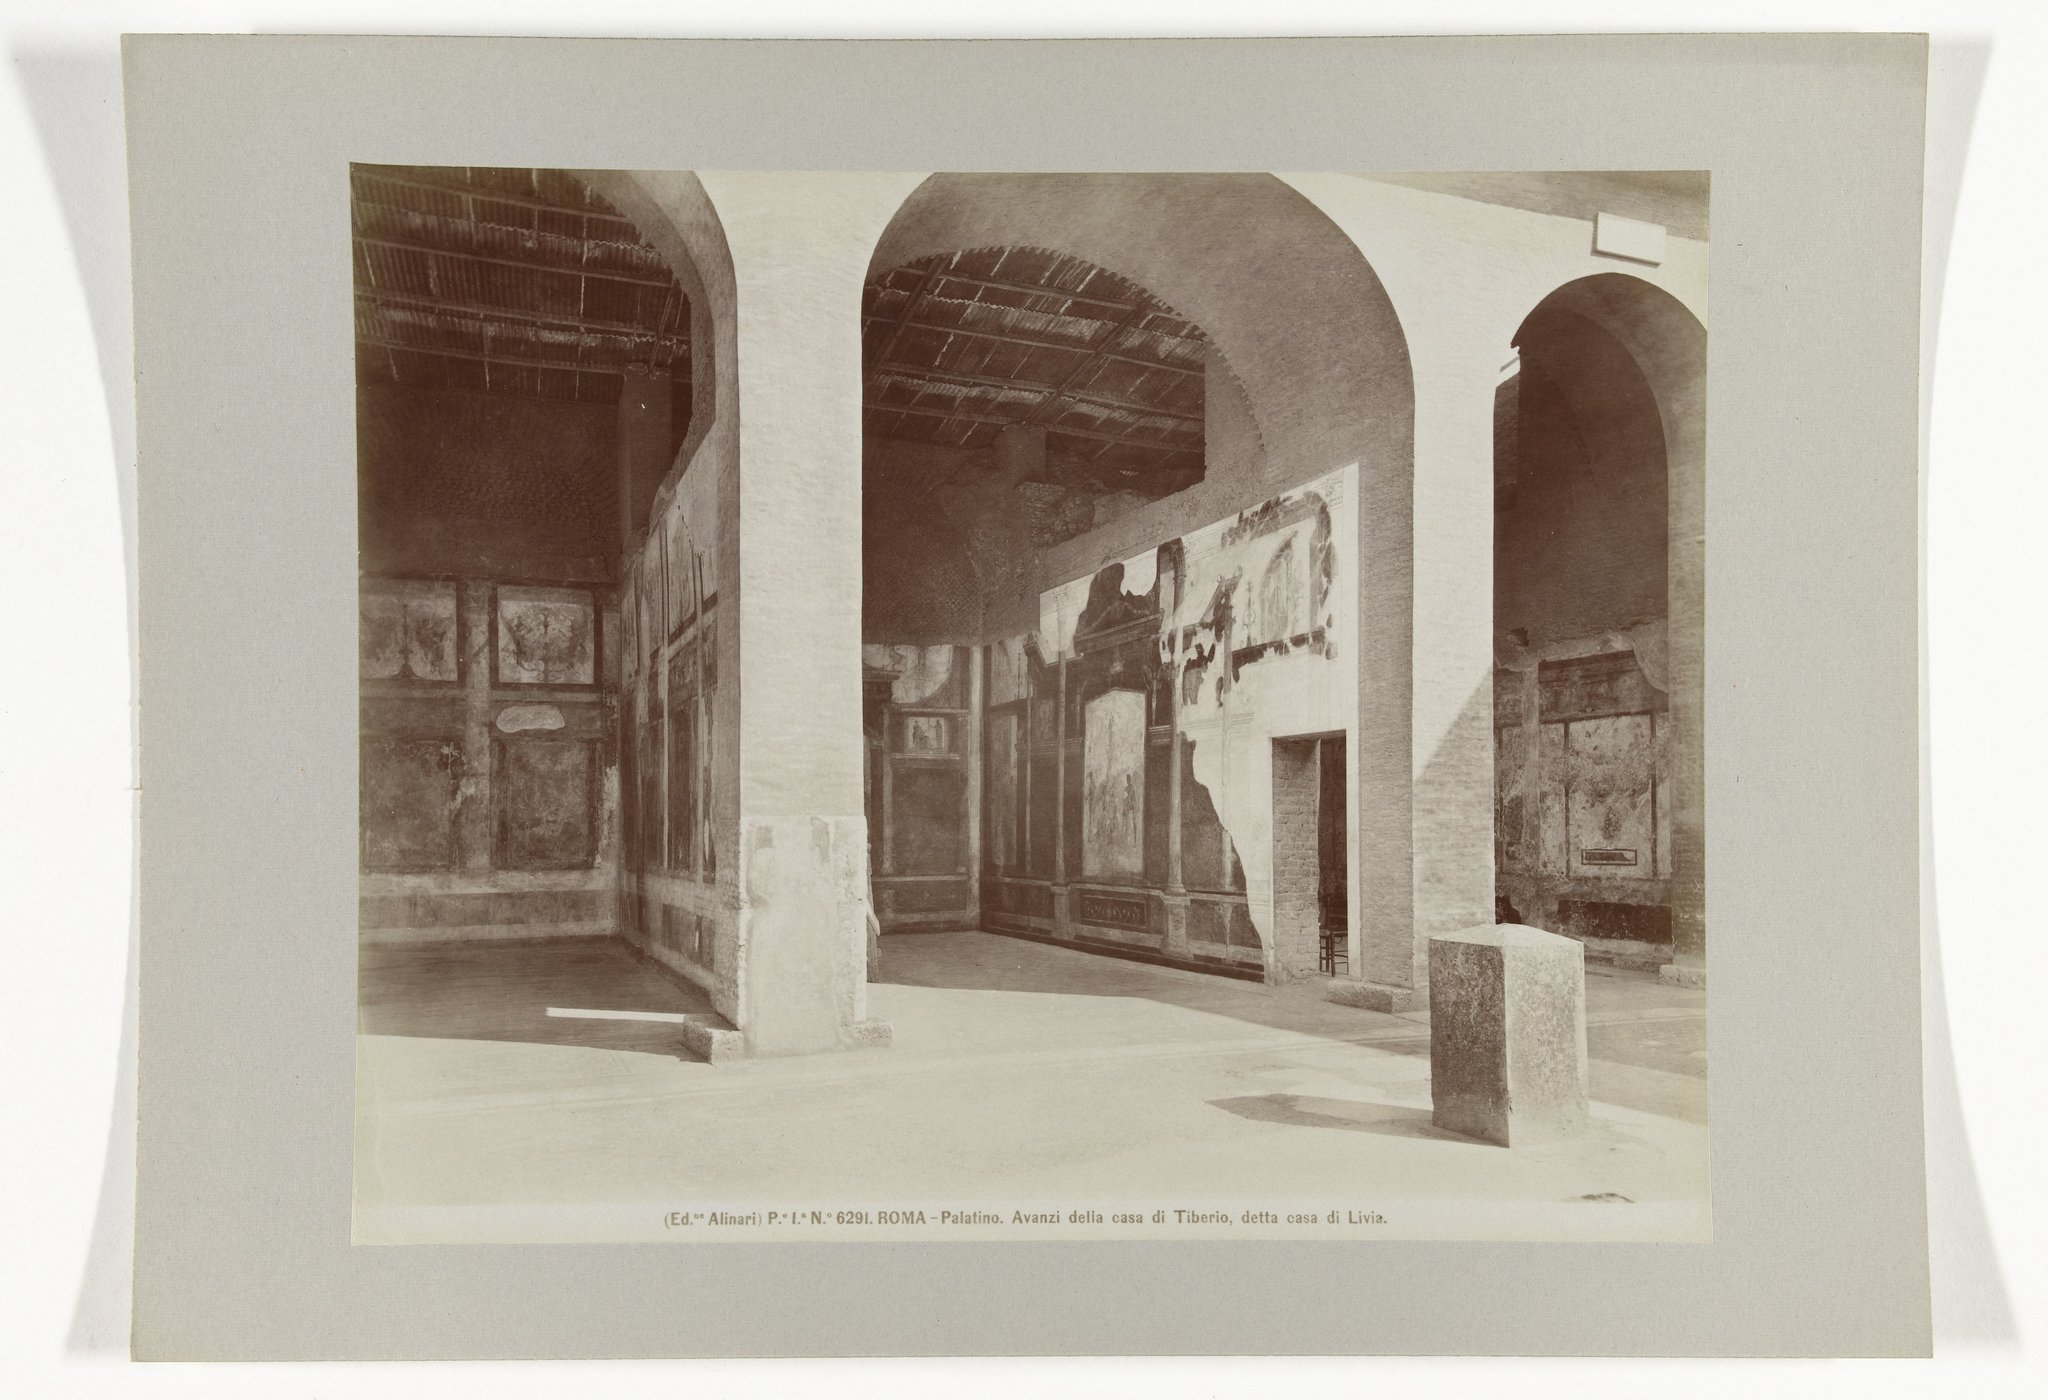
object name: photograph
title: P.e 1.a N.o 6291. ROMA - Palatino. Avanzi della casa di Tiberio, detta casa di Livia.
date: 1880-1895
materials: cardboard, paper, photographic support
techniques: albumen print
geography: florence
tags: ruin of a building ~ architecture, palace, rome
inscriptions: number: ‘16.’